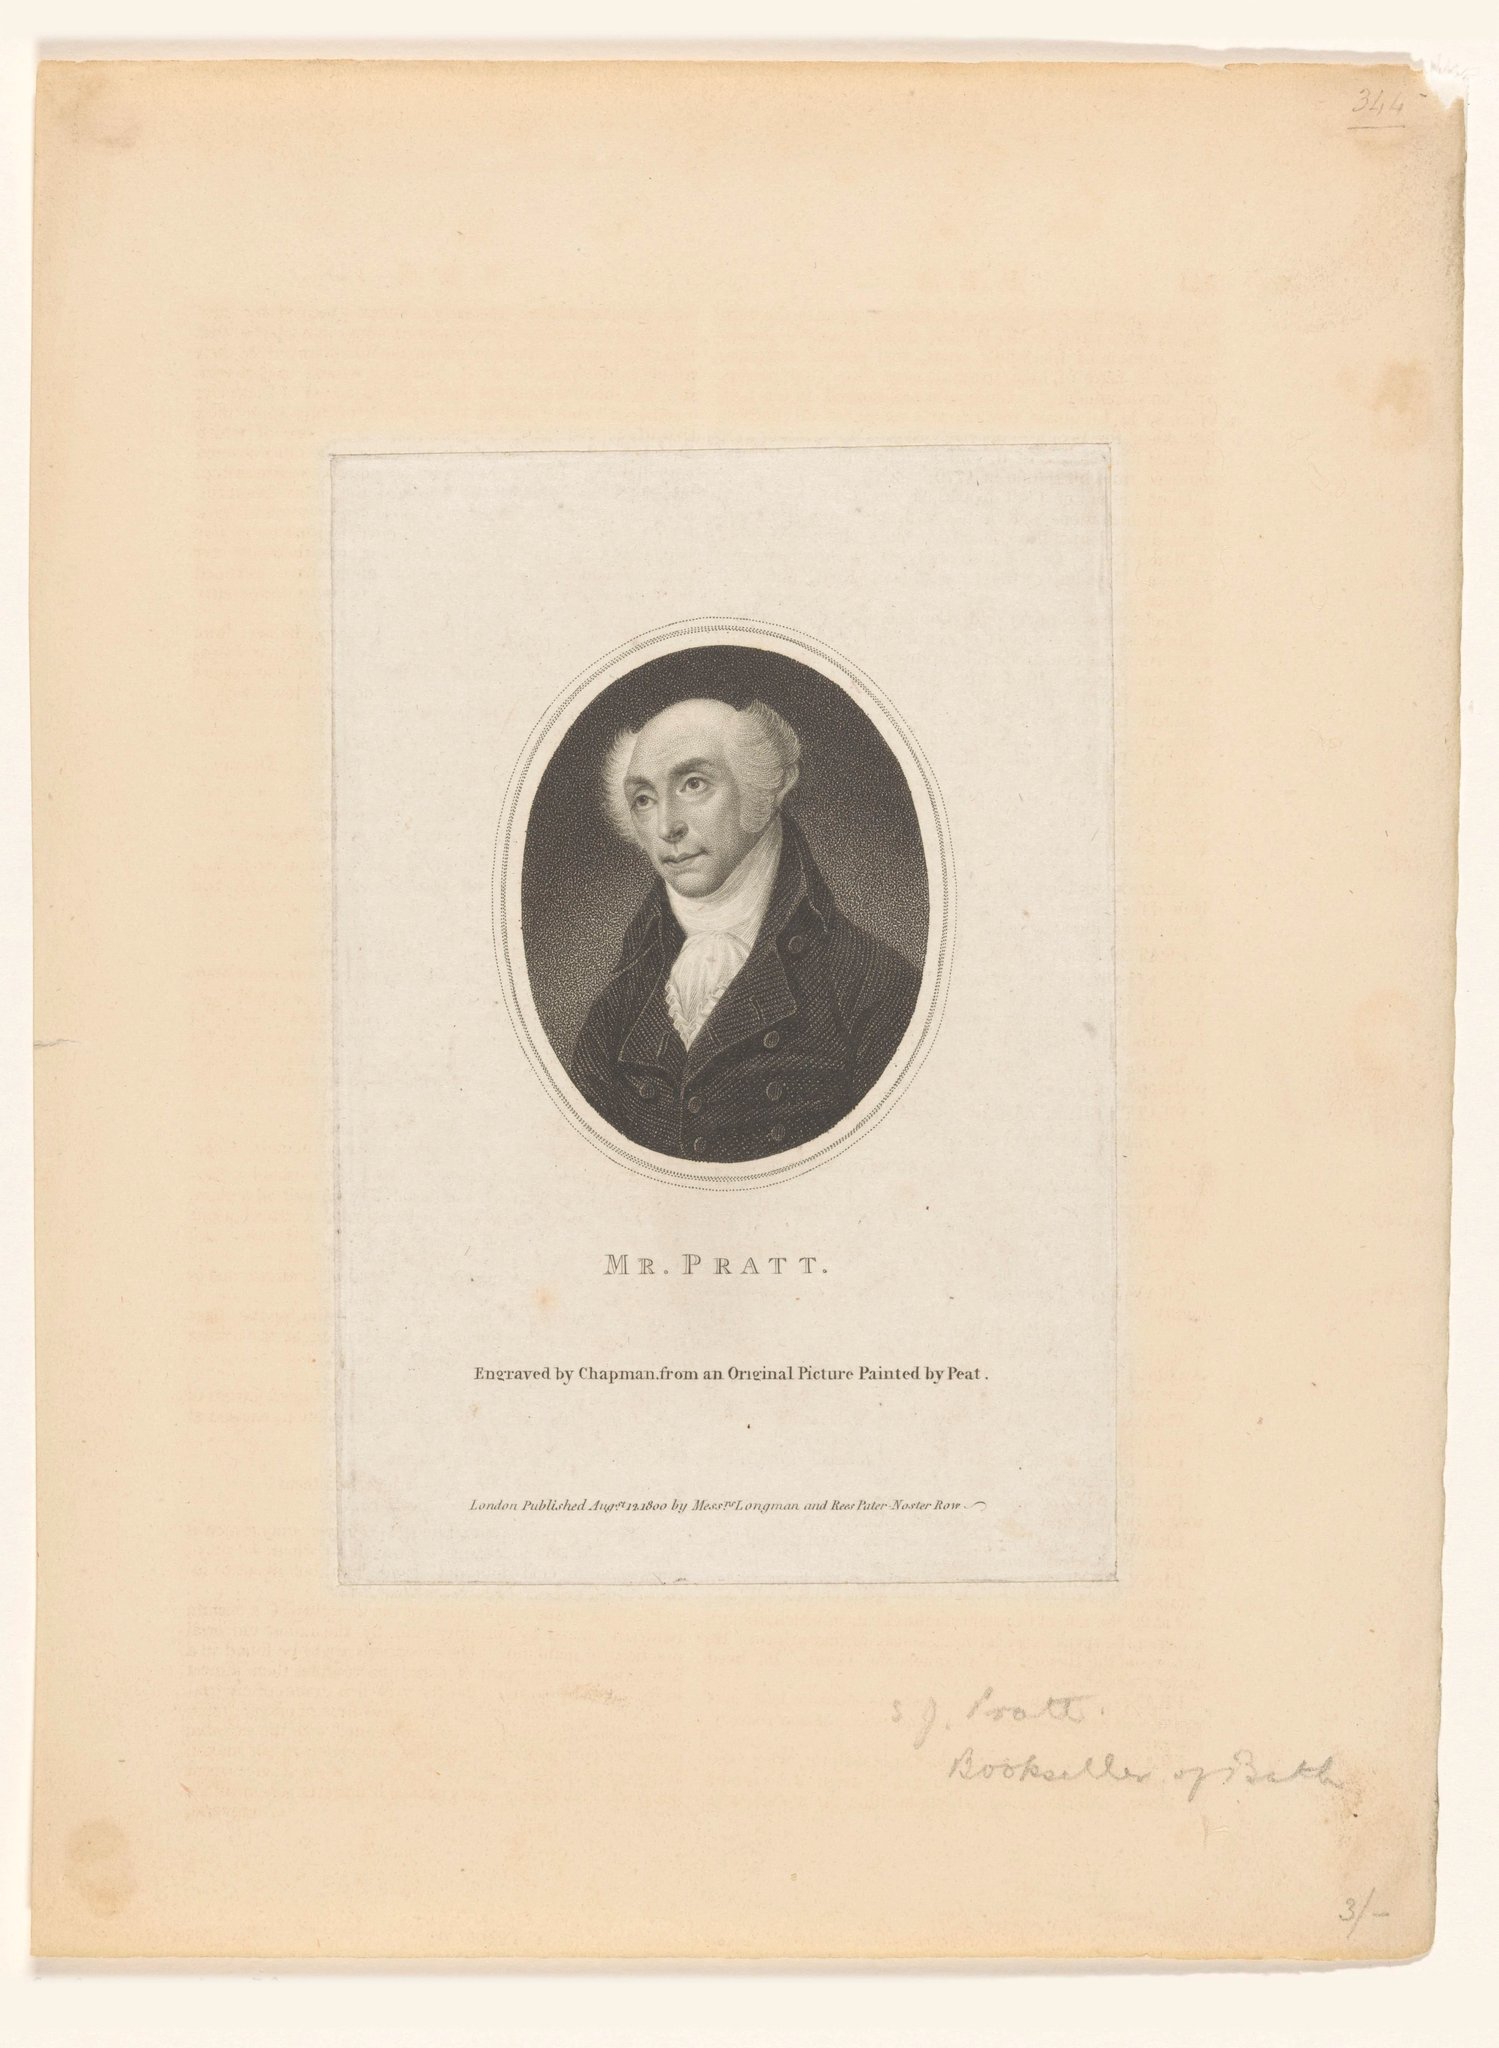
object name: print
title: Portret van schrijver Samuel Jackson Pratt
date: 1800-1808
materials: paper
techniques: stippled etching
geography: london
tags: writer, poet, author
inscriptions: collector's mark: Lugt 4779, inscription: ‘S.J. Pratt Bookseller in Bath’, collector's mark: Lugt 2228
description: Pratt was ook korte tijd mede-eigenaar van een boekhandel in Bath.